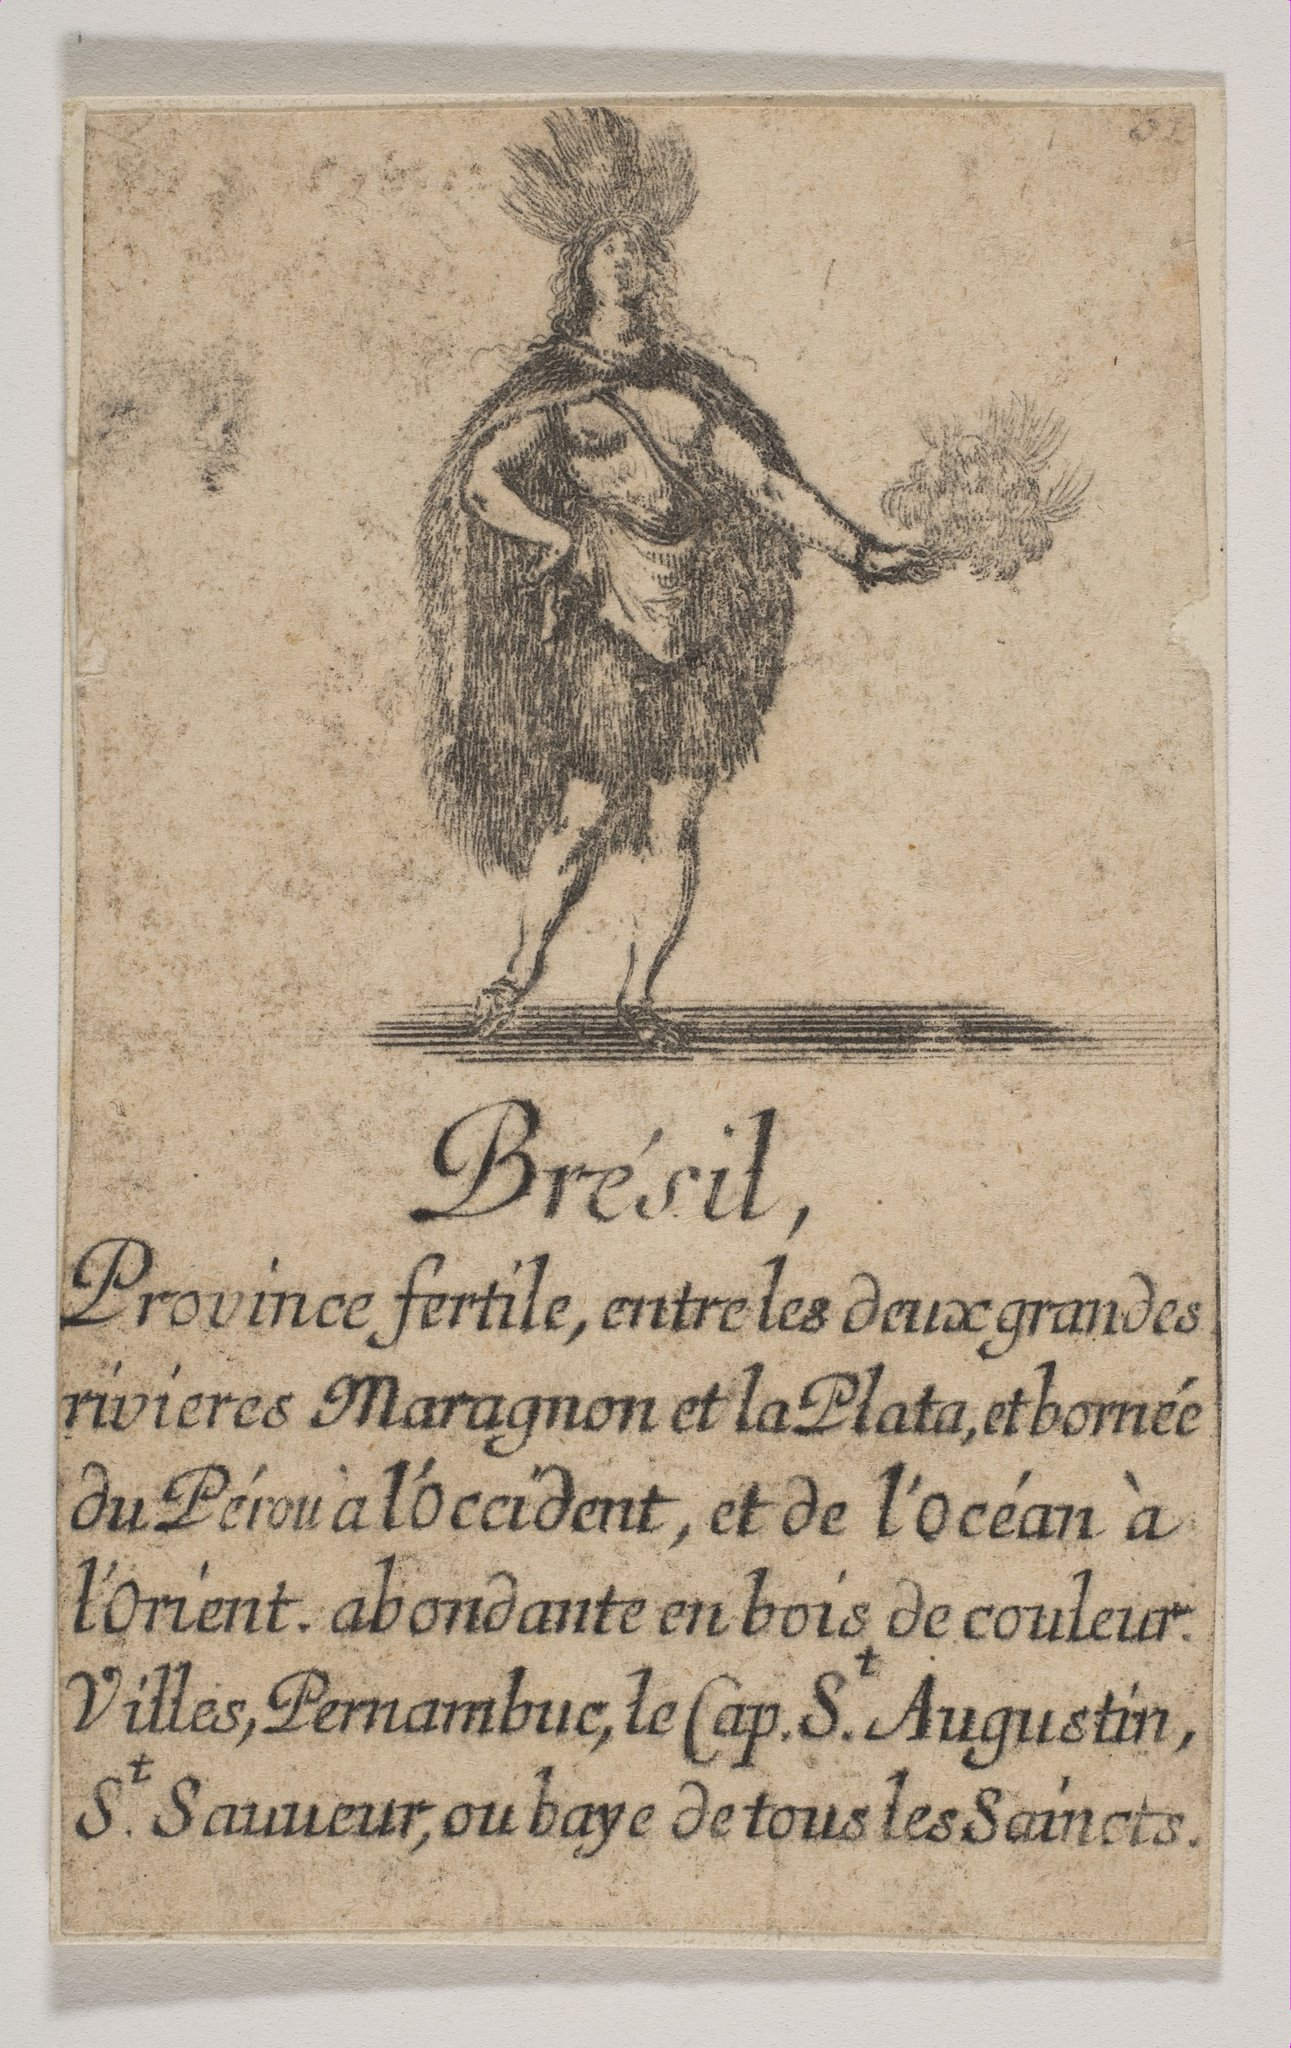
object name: print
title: Brésil, from the playing cards "Jeu de la Géographie"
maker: stefano della bella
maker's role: artist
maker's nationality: italian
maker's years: 1610-1664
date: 1644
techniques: etching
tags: men